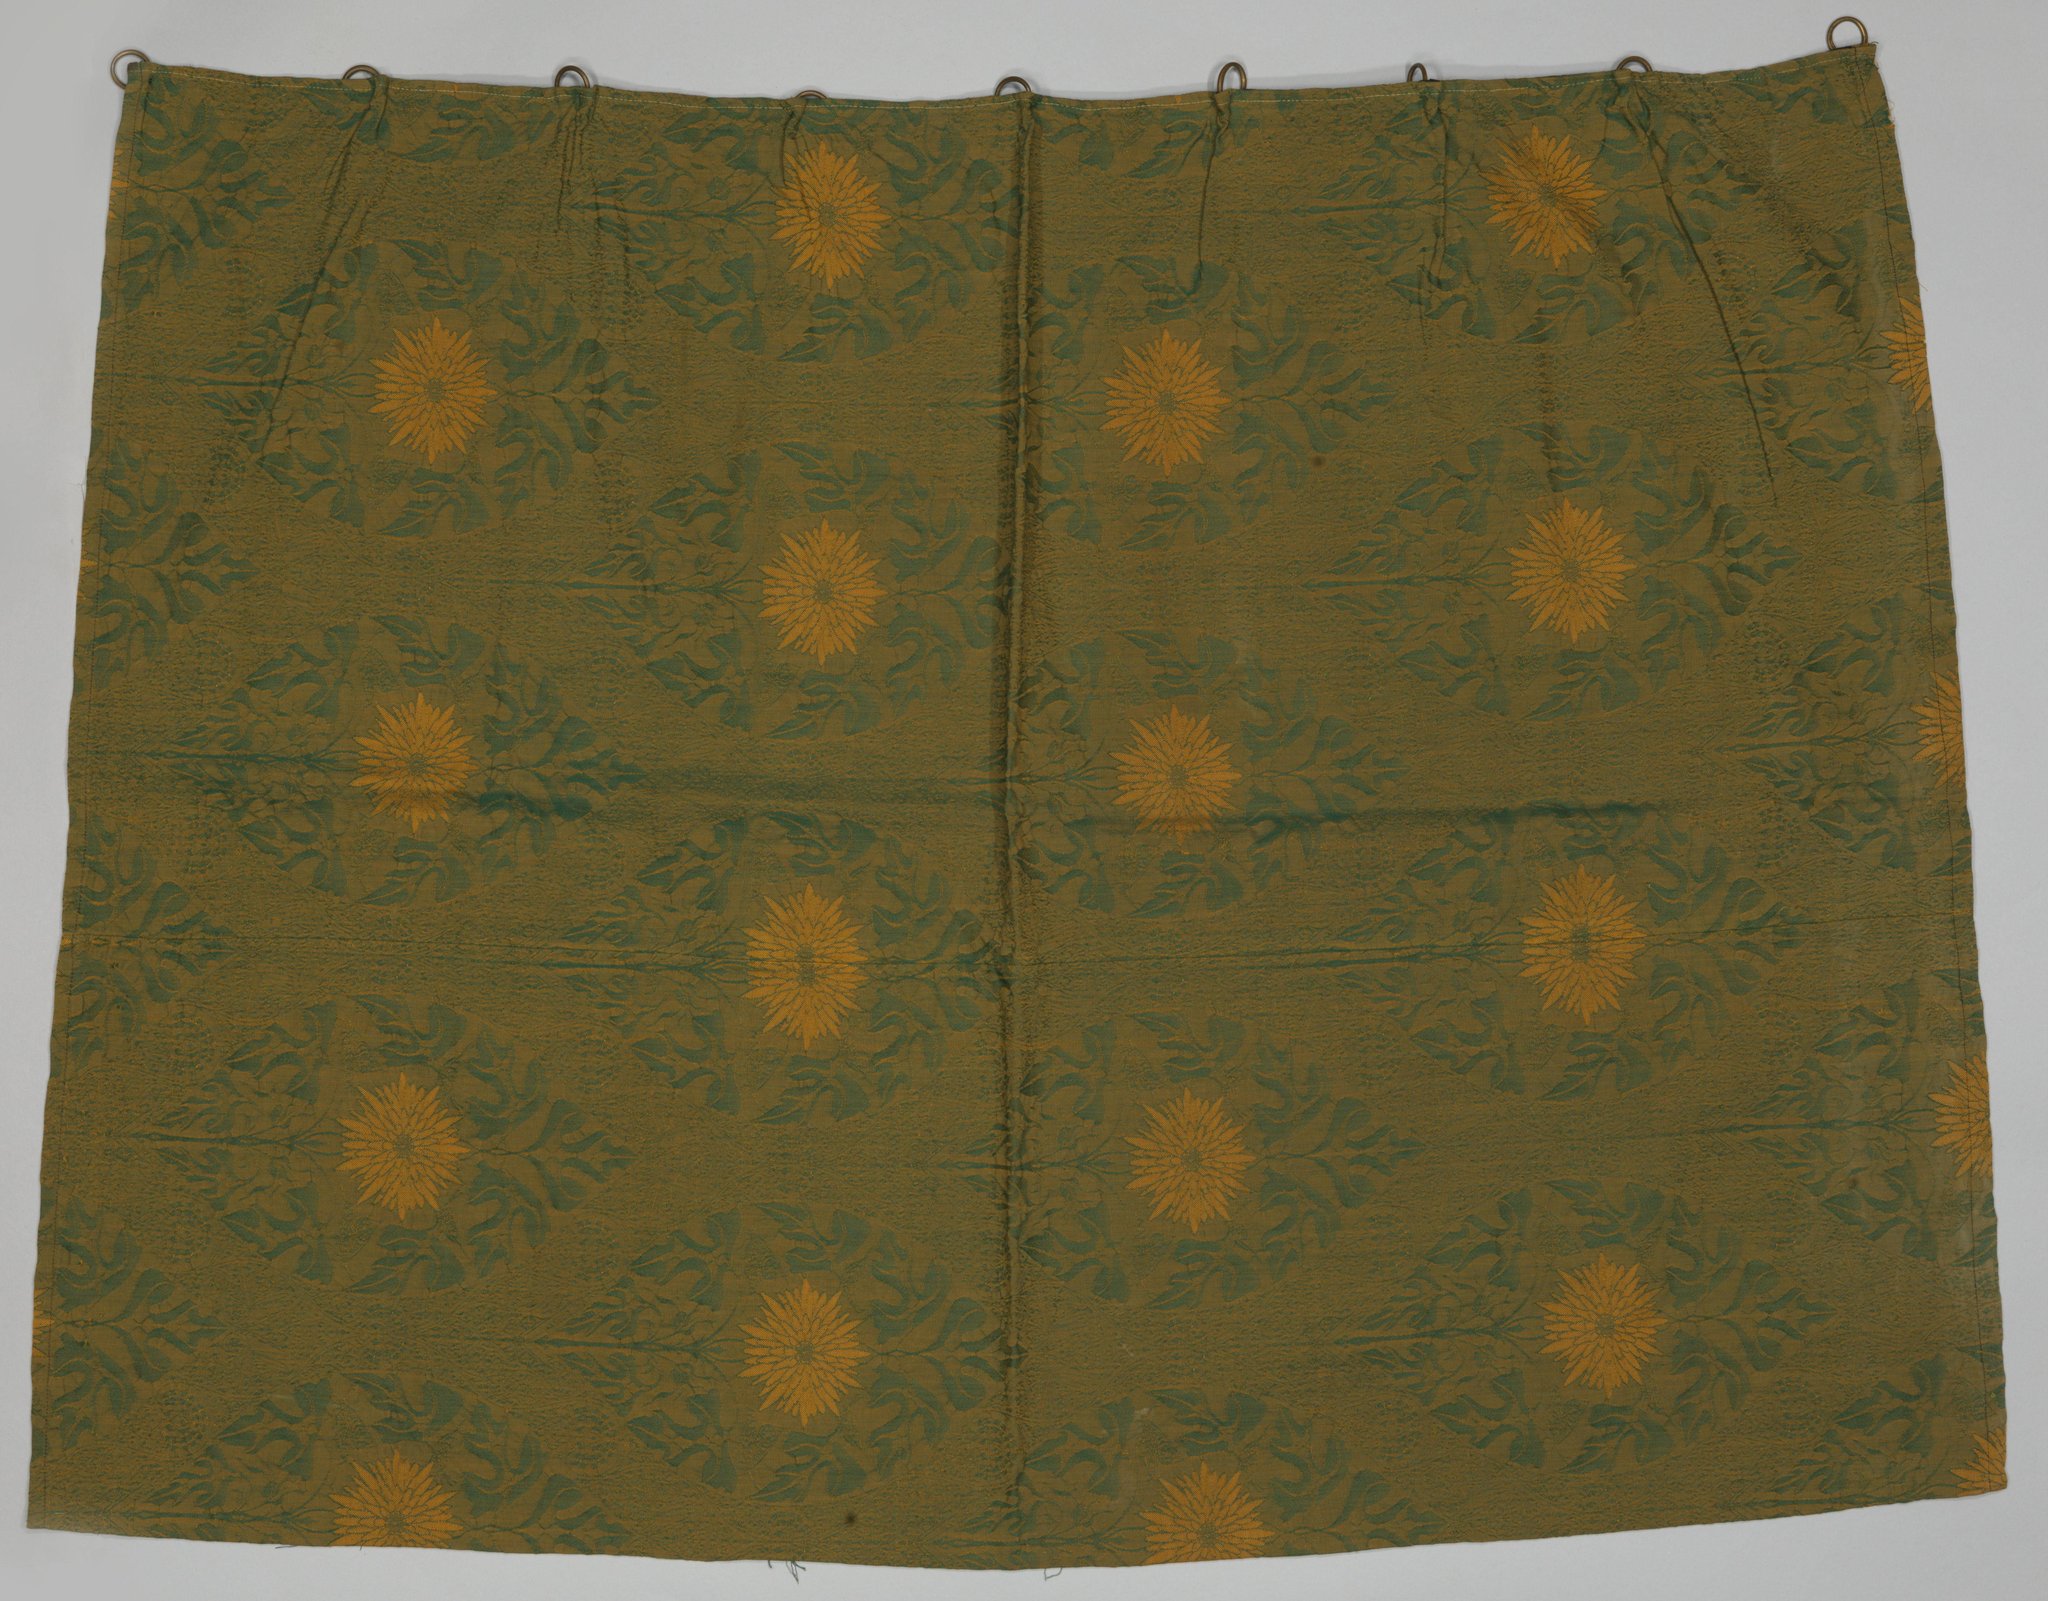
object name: curtain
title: Gordijn met patroon van bloem binnen brede spitsovale banden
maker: theo nieuwenhuis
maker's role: designer, draughtsman, print maker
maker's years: 1866-1951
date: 1900-1925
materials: cotton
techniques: jacquard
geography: helmond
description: Gordijn met patroon van bloem binnen brede spitsovale banden. Gele inslag op groene ketting.